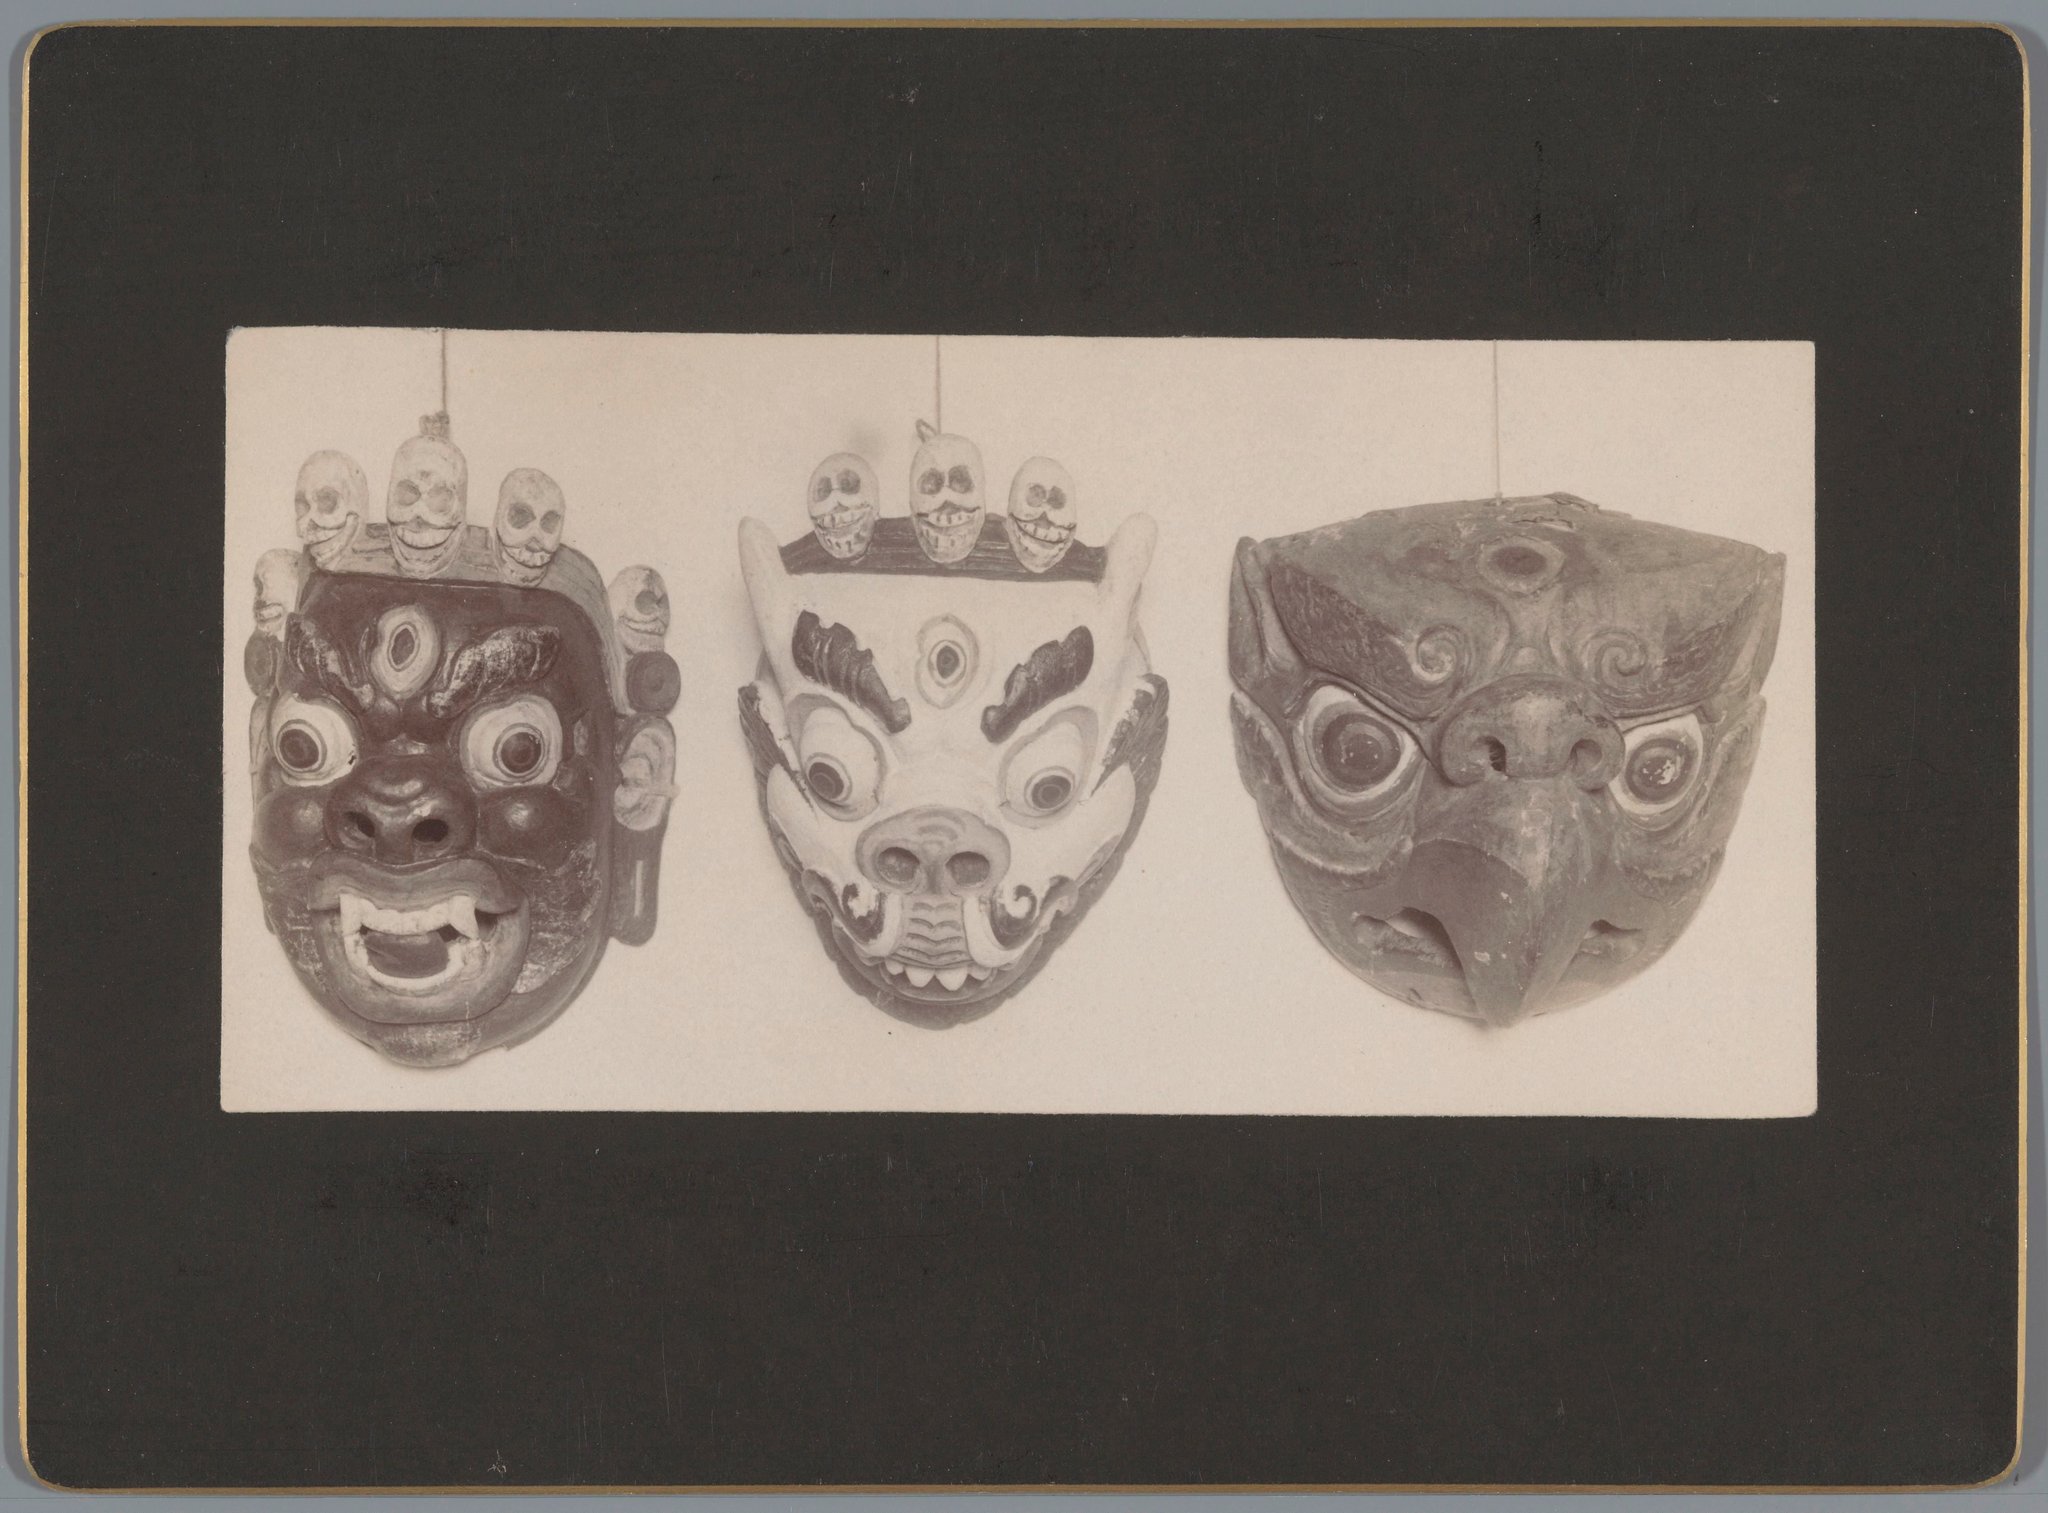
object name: photograph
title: Drie Tibetaanse maskers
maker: Anonymous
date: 1897-1910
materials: cardboard, paper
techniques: albumen print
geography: tibet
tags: mask